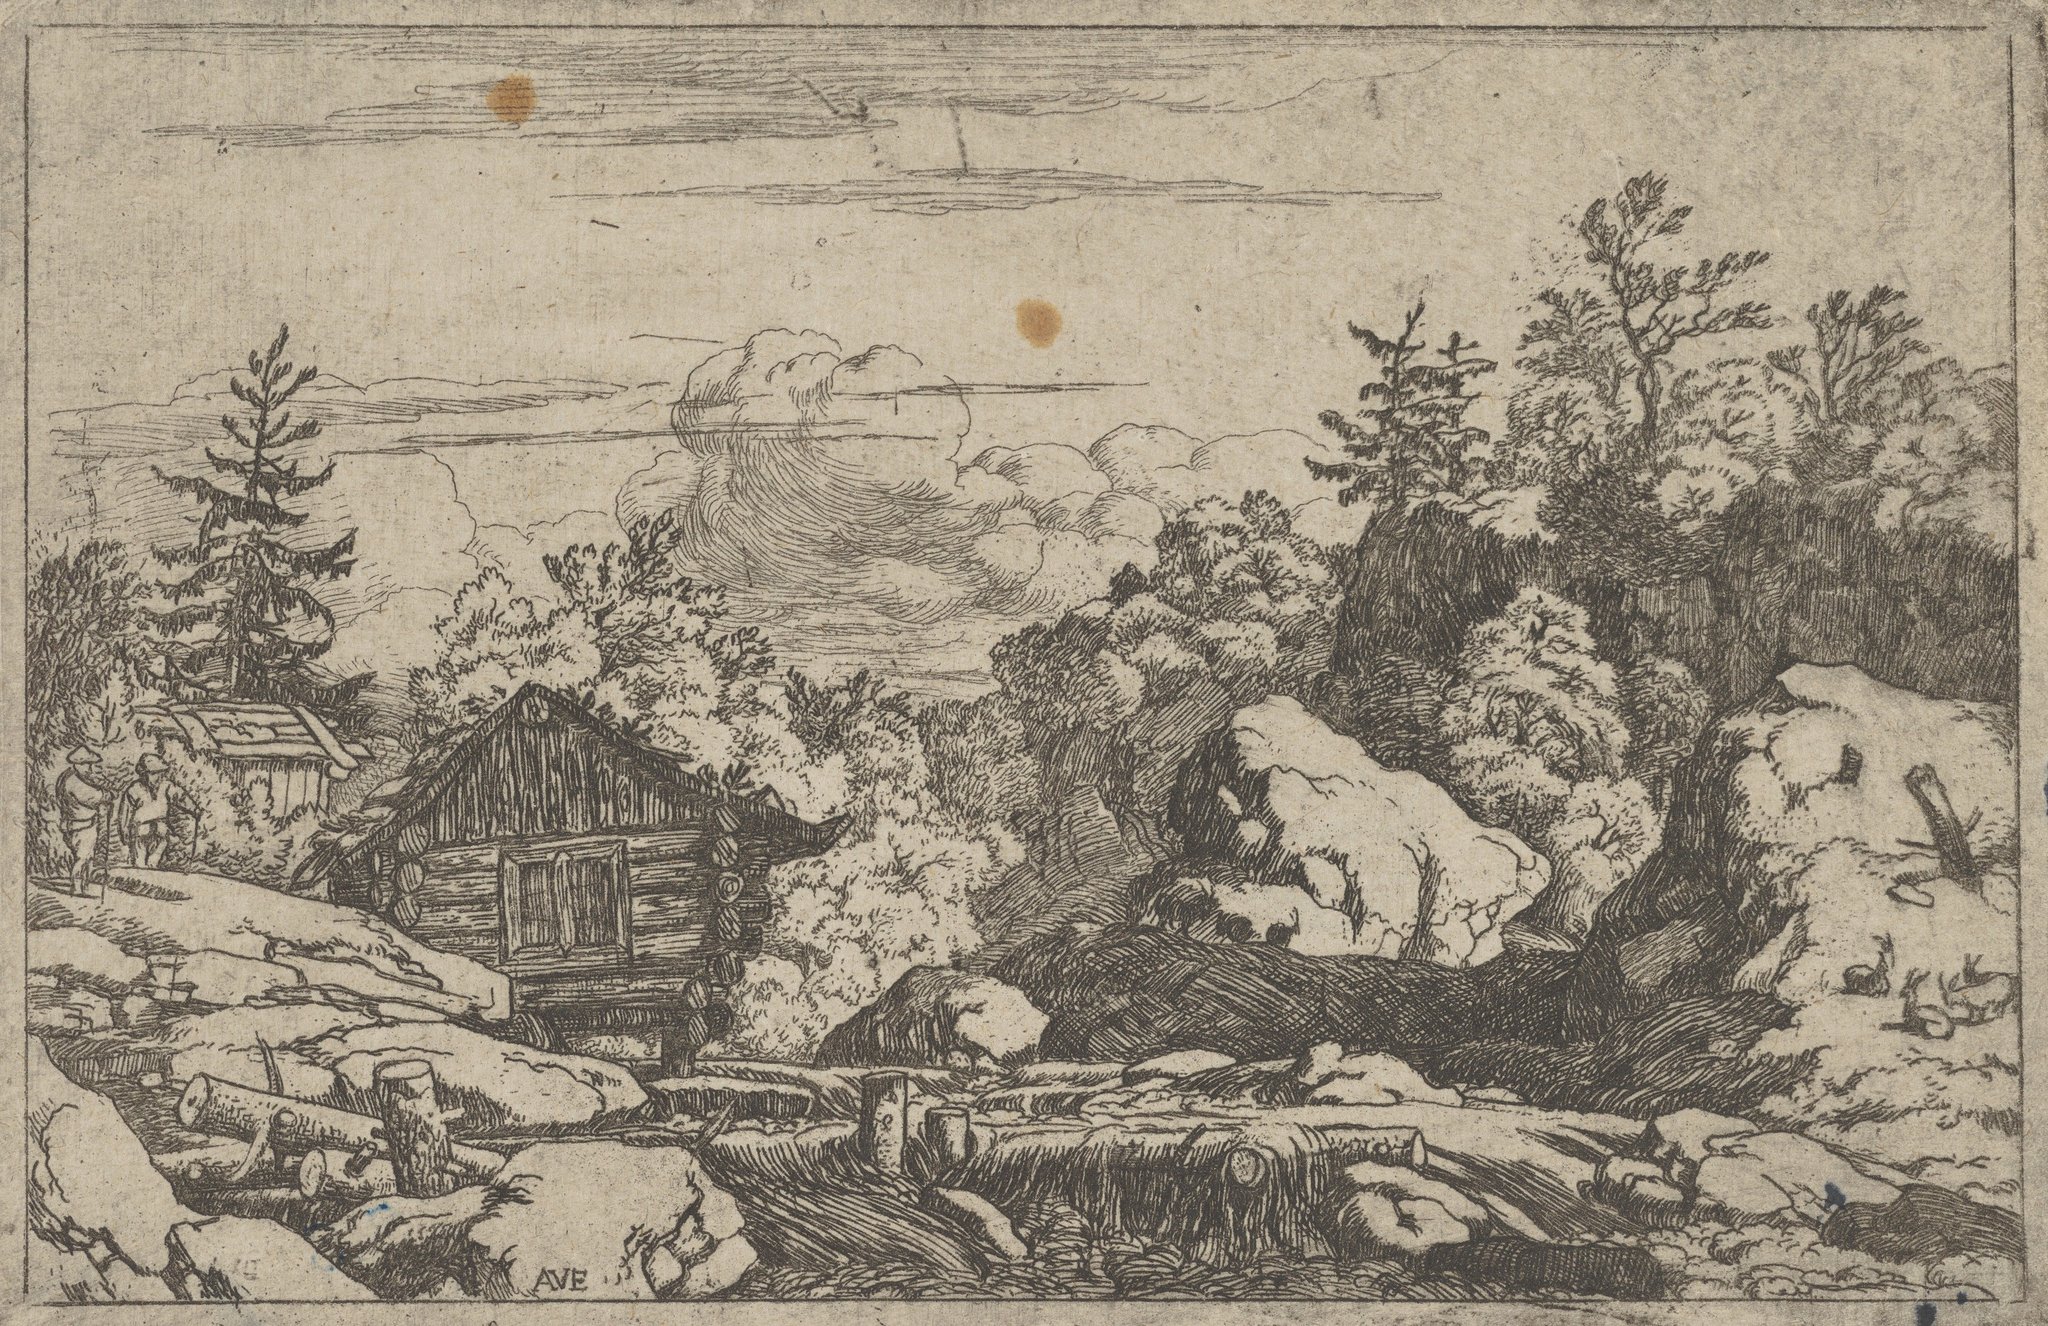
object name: print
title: The Cottages at the Bank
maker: allart van everdingen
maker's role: artist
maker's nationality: dutch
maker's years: 1621-1675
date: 1621-1675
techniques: engraving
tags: houses,trees